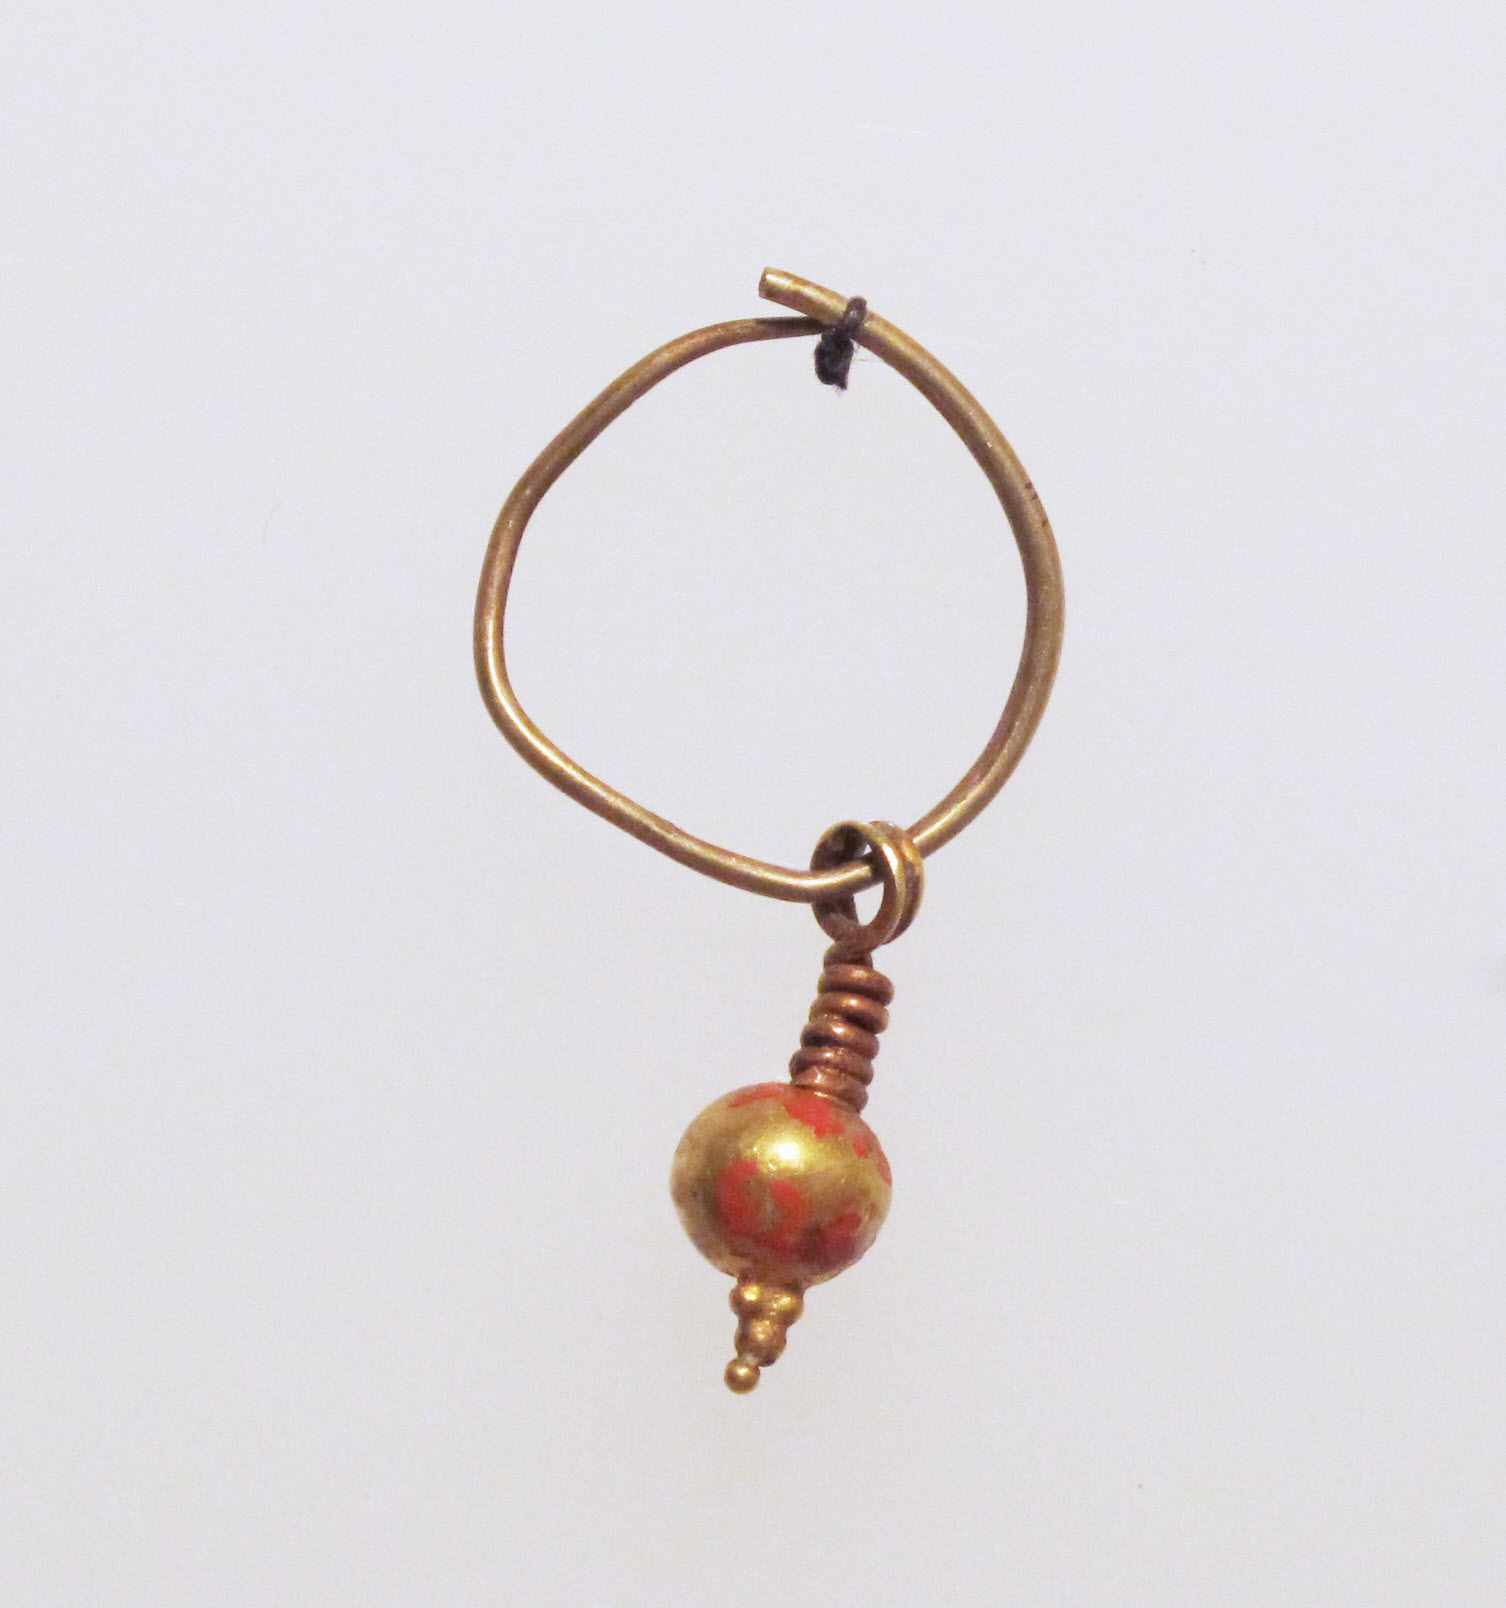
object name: earring with pendant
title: Gold earring with pendant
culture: roman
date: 101-200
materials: gold